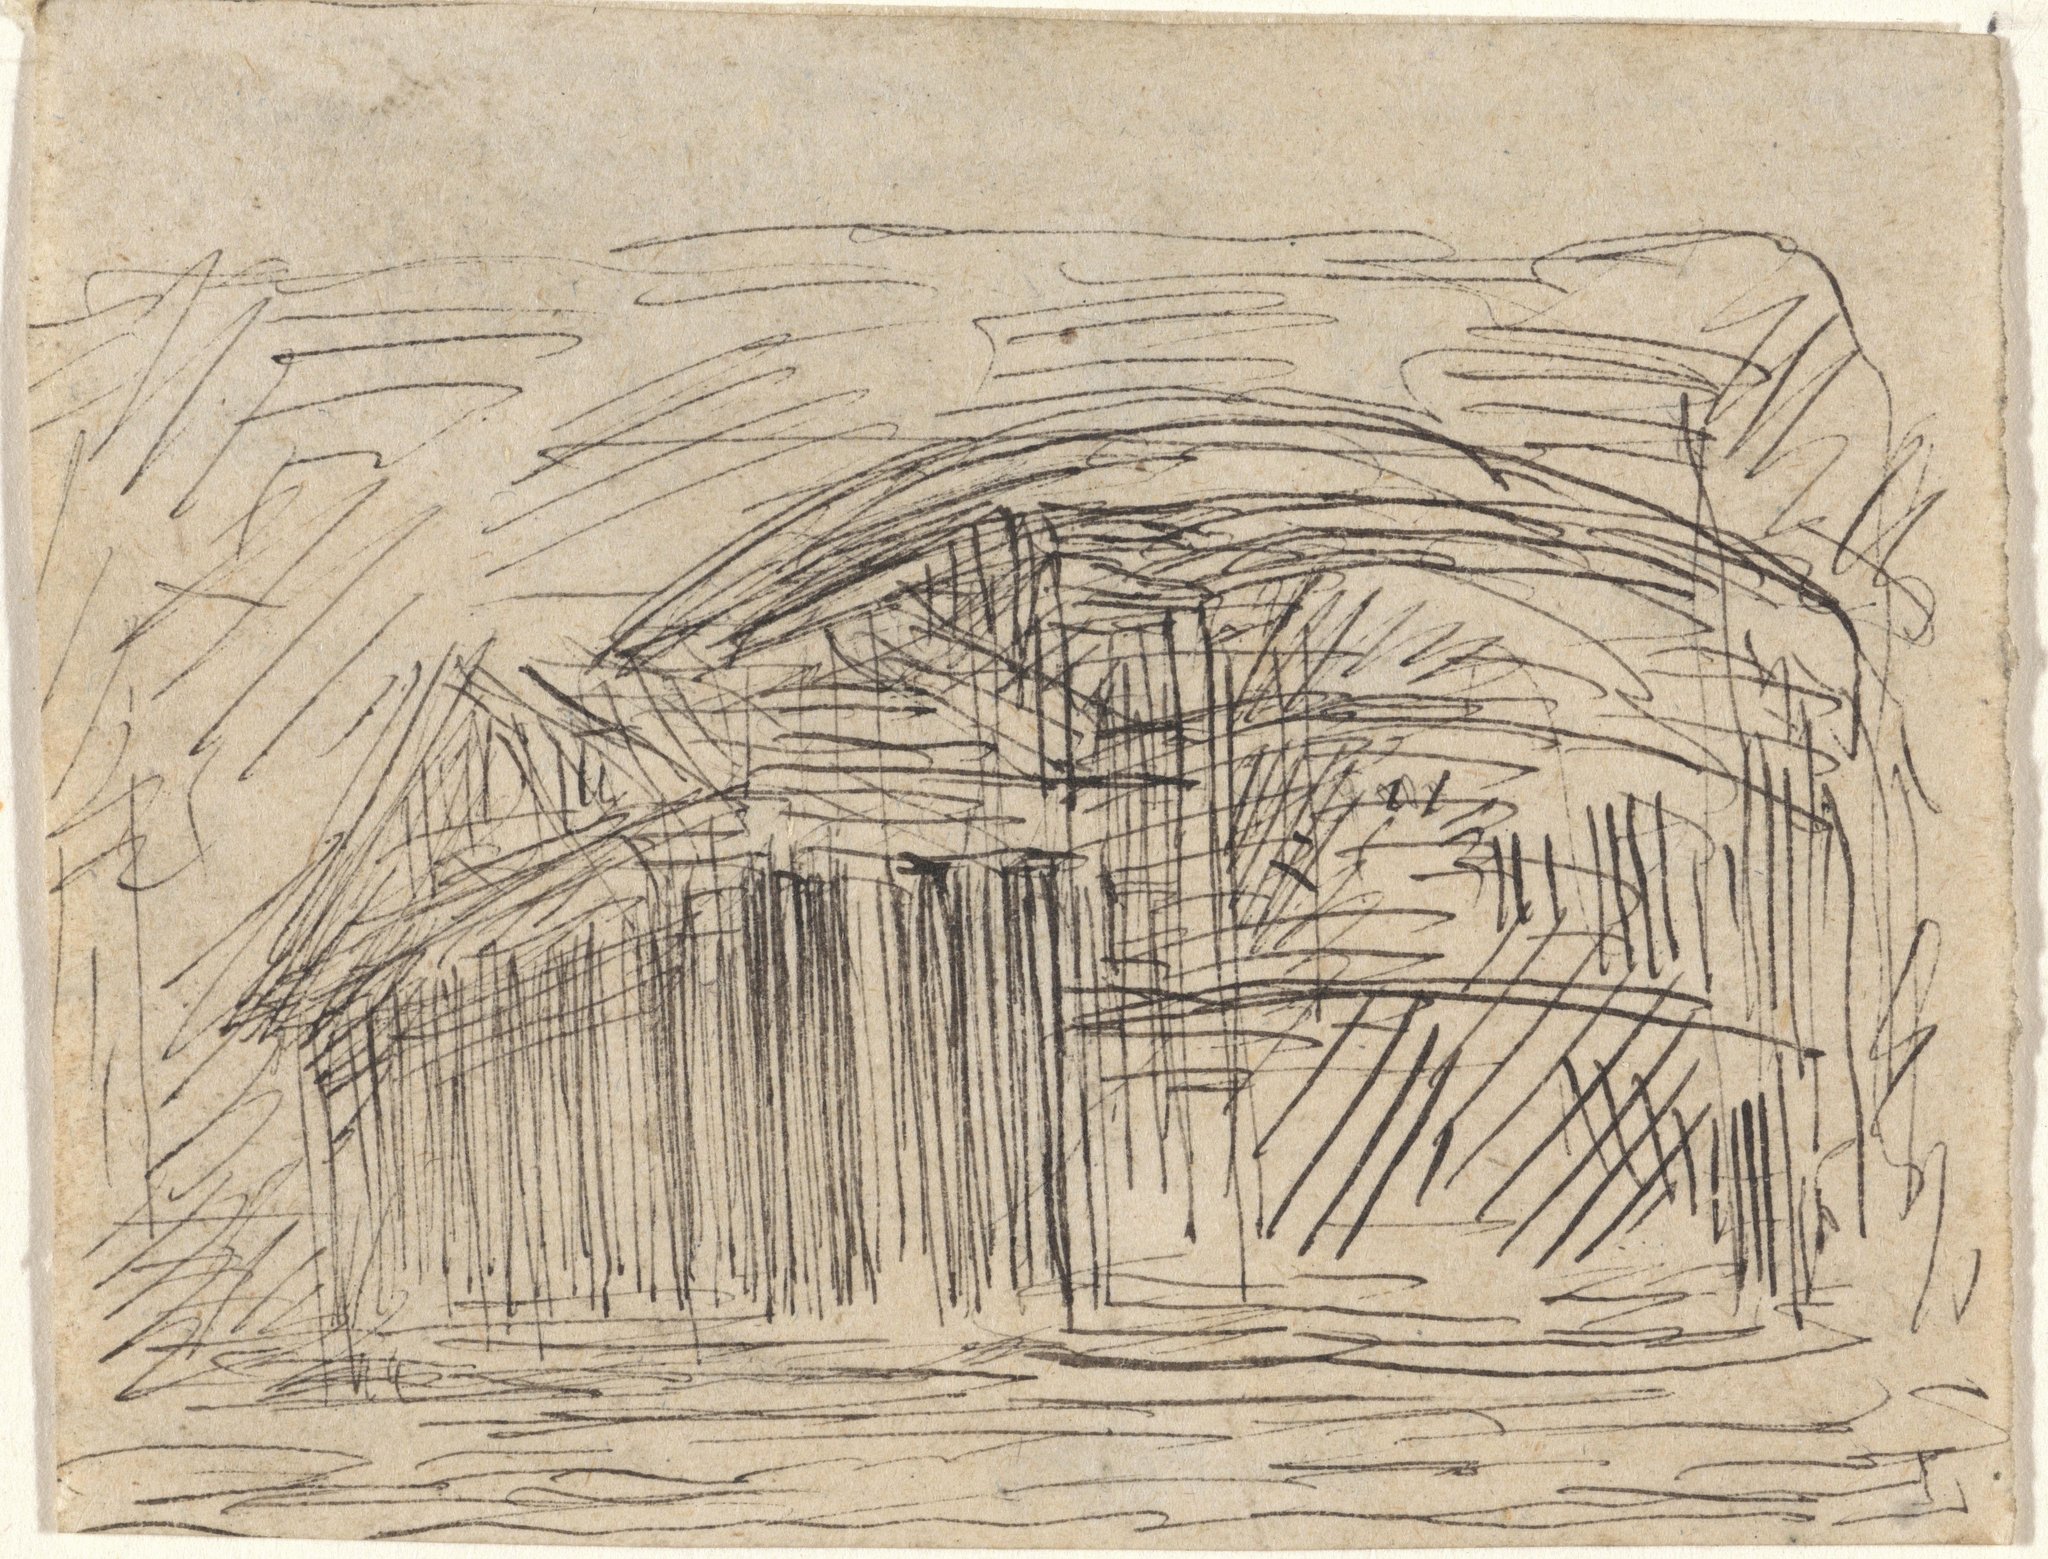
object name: drawing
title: Het Pantheon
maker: thomas cool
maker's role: draughtsman, painter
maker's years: 1851-1904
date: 1861-1904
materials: ink, paper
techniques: pen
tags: city-view, and landscape with man-made constructions, temple, shrine ~ non-christian religions